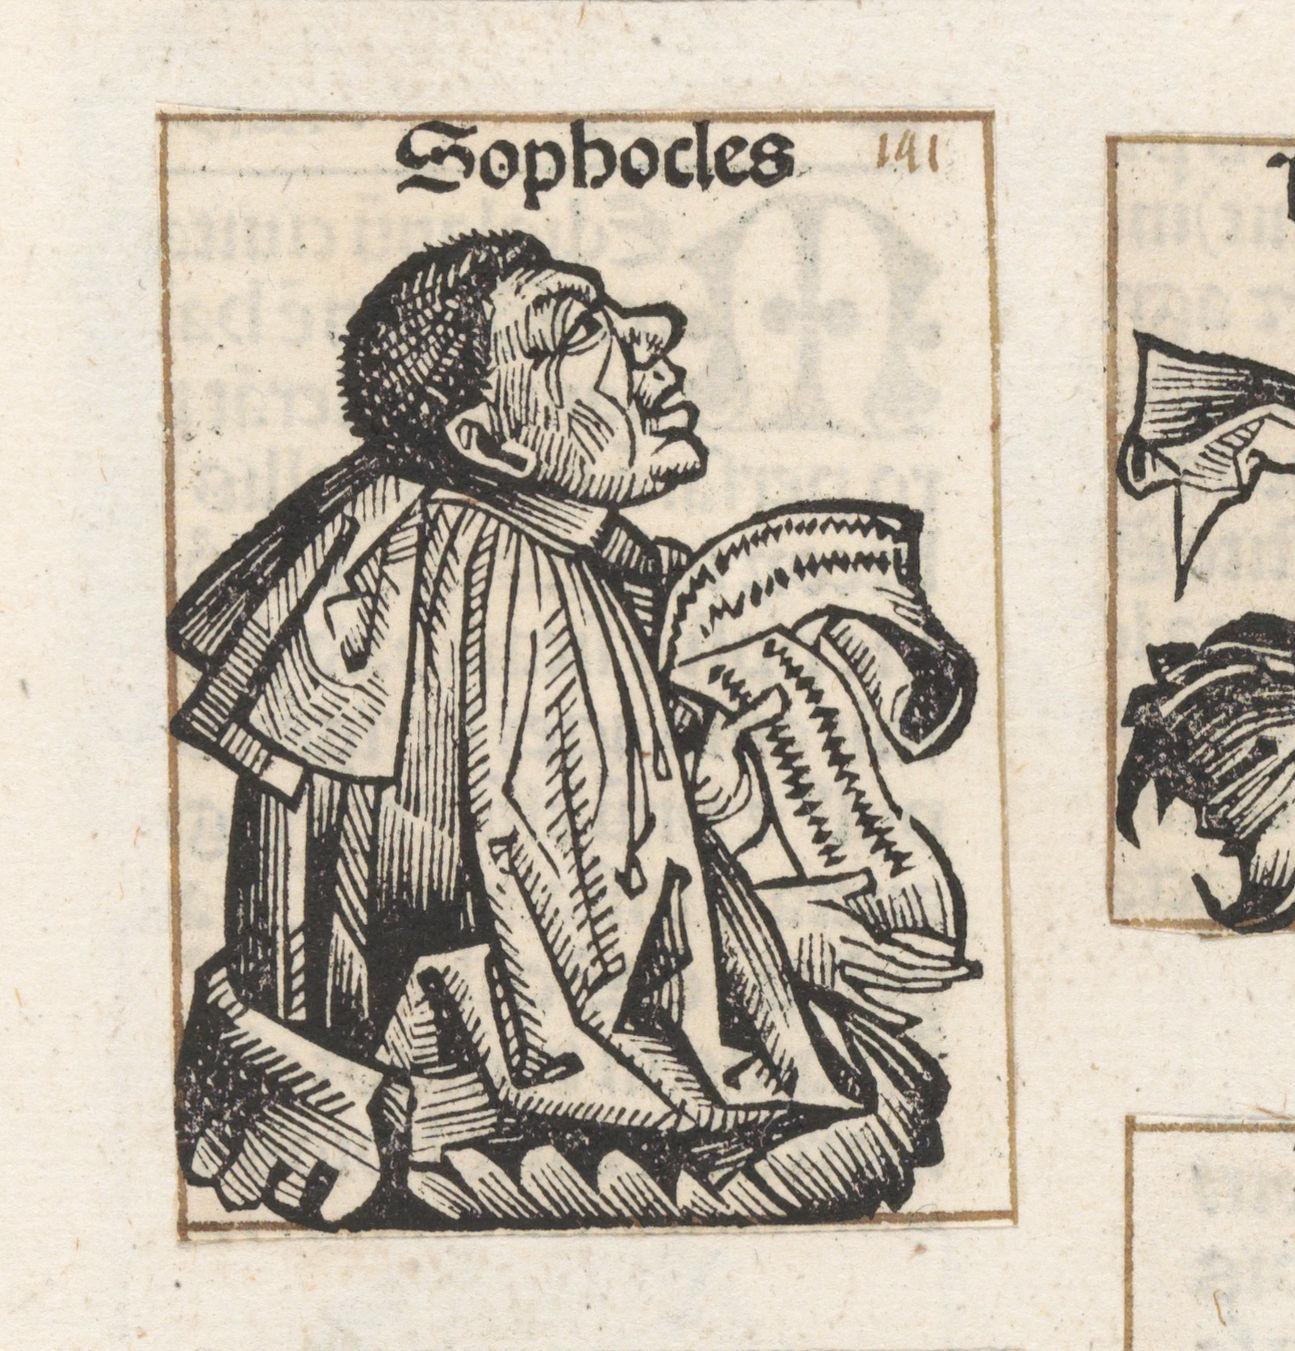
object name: print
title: Sophocles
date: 1493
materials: paper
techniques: letterpress printing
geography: nuremberg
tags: sophocles, male persons from classical history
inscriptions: inscription: ‘141’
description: De houtsnede wordt gebruikt als boekillustratie in de Liber Chronicarum (of Neurenbergkroniek) van Hartmann Schedel, verschenen in het Latijn en Duits in 1493. Zie de Latijnse uitgave, folio 72v.